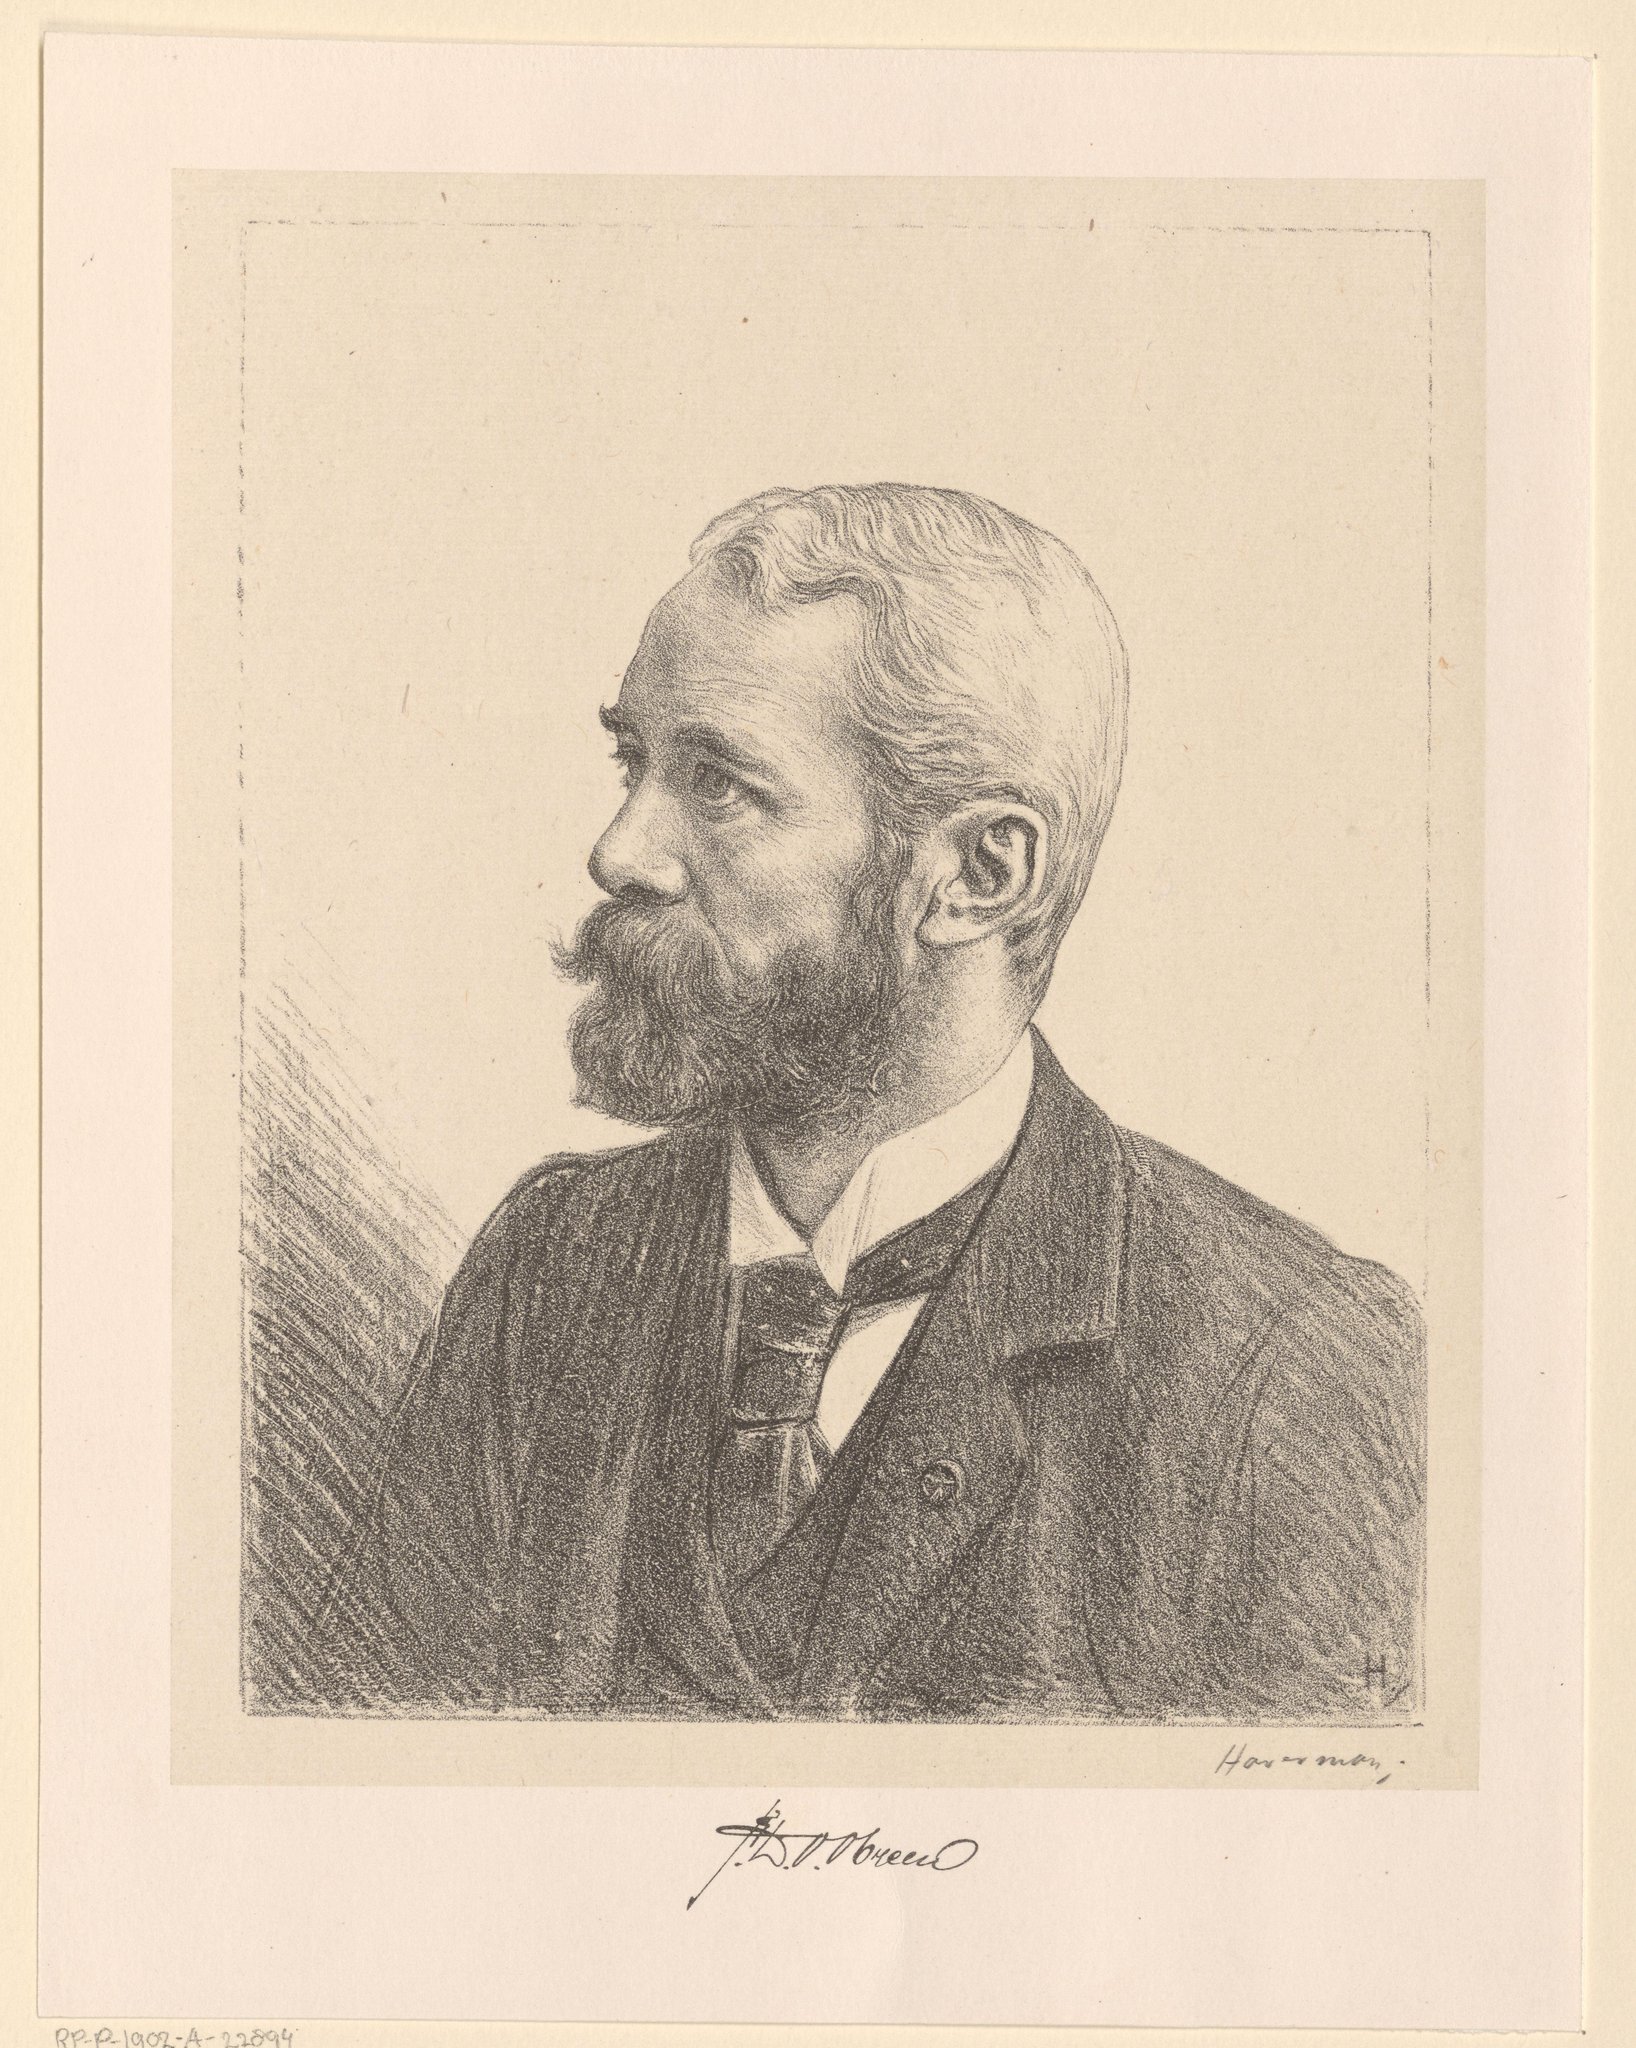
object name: print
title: Portret van Frederik Daniel Otto Obreen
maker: hendrik johannes haverman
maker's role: draughtsman, print maker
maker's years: 1857-1928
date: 1867-1902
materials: paper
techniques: lithograph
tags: rotterdam, draughtsman, frederik daniel otto obreen, historical persons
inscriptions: collector's mark: Lugt 2228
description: Onder het portret een facsimile van de handtekening van de geportretteerde.